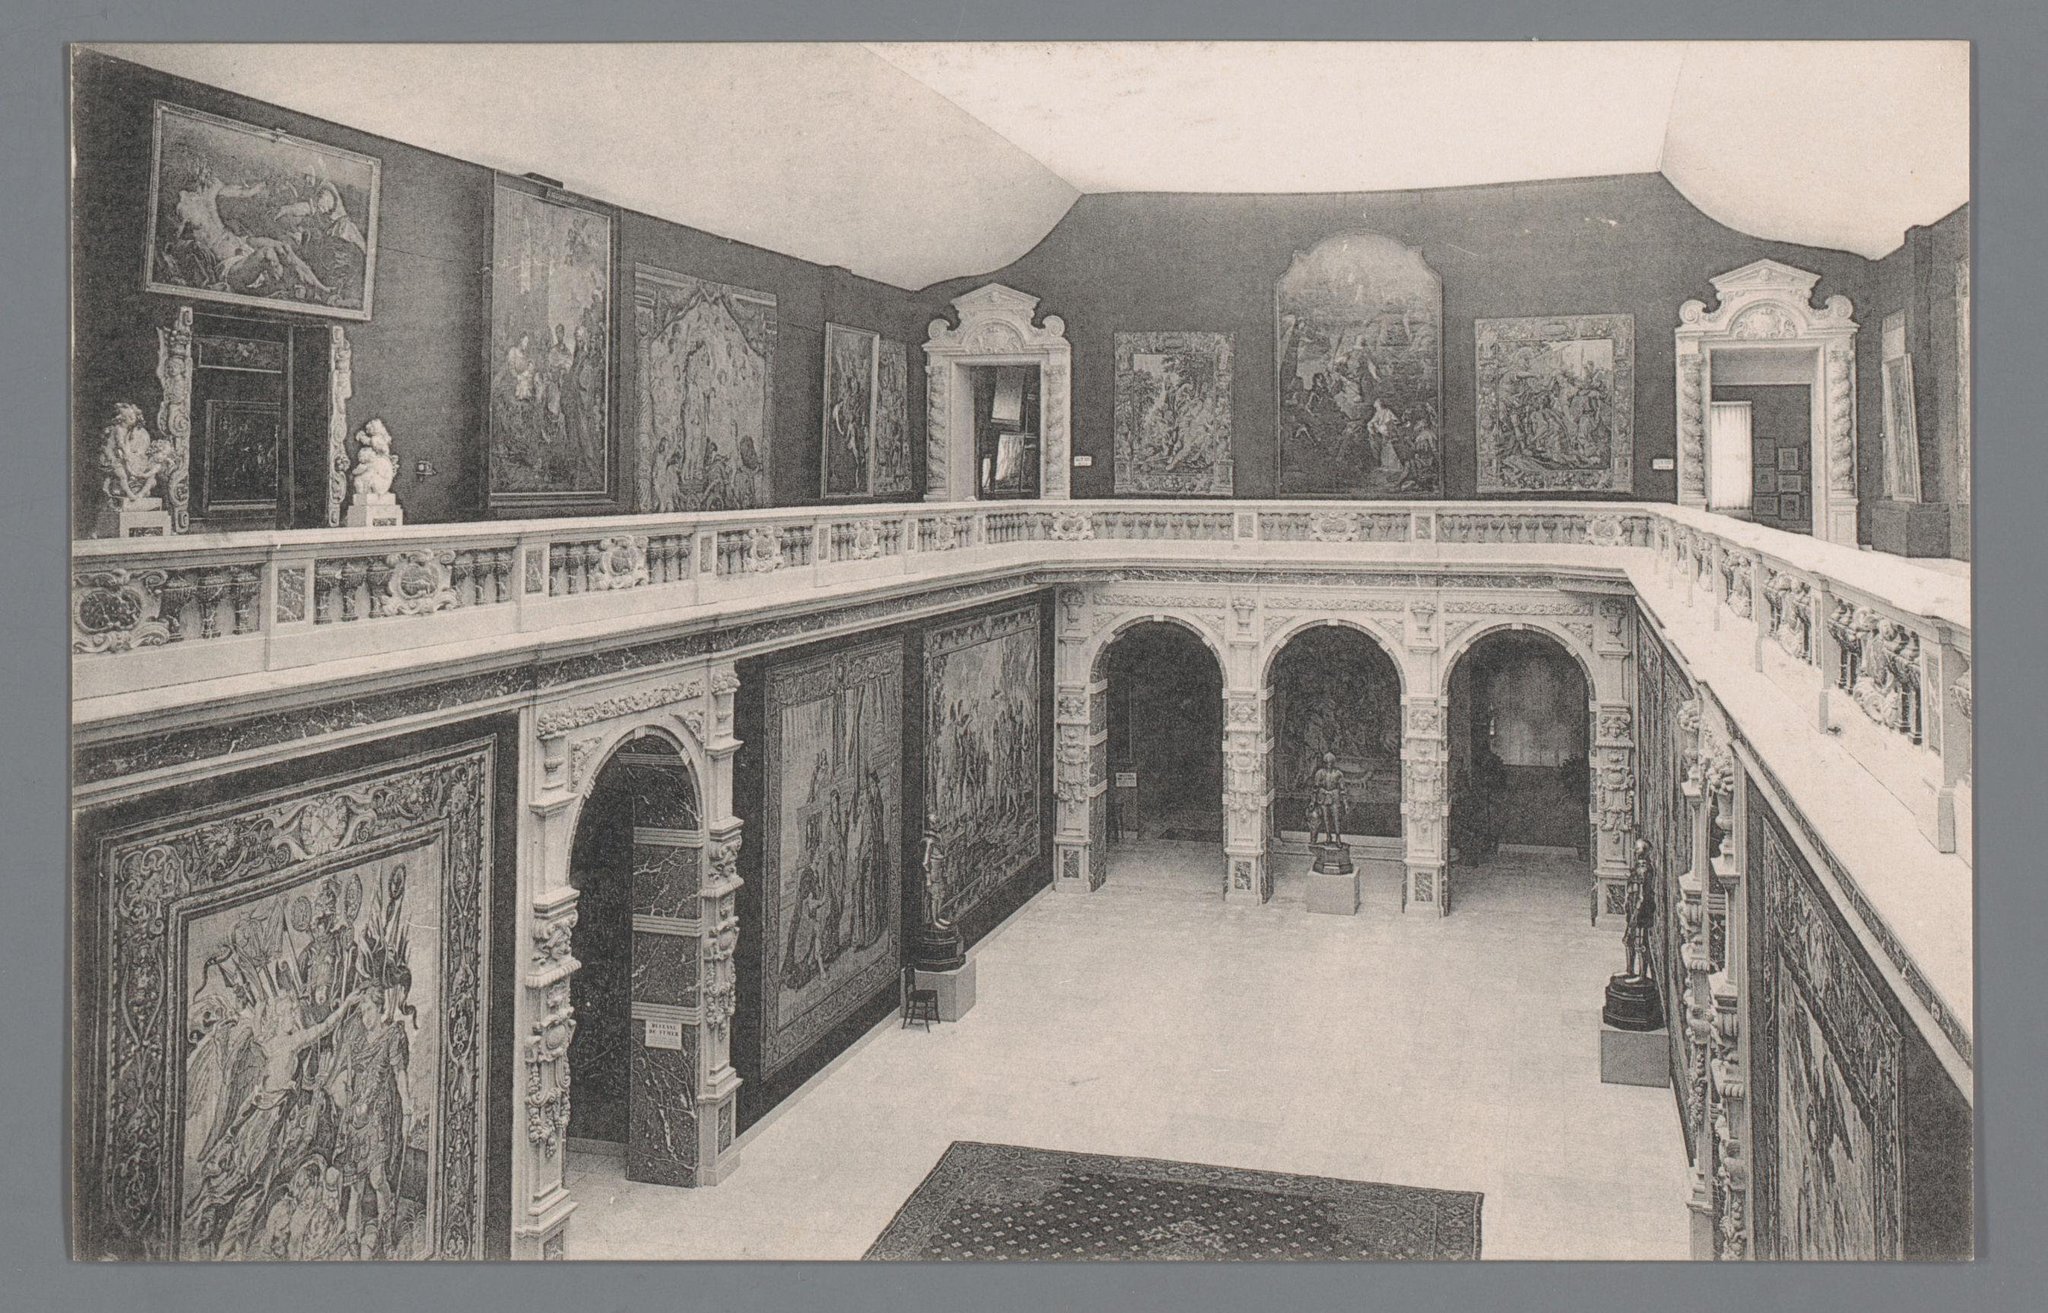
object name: ansichtkaart, prentbriefkaart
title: Exposition d'Art Ancien "Le XVIIme siècle"... ...Bruxelles 1910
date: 1910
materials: paper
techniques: photography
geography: brussels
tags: brussels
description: Briefkaart, zwart-wit: Interieurs tentoonstelling over de 17de eeuw.